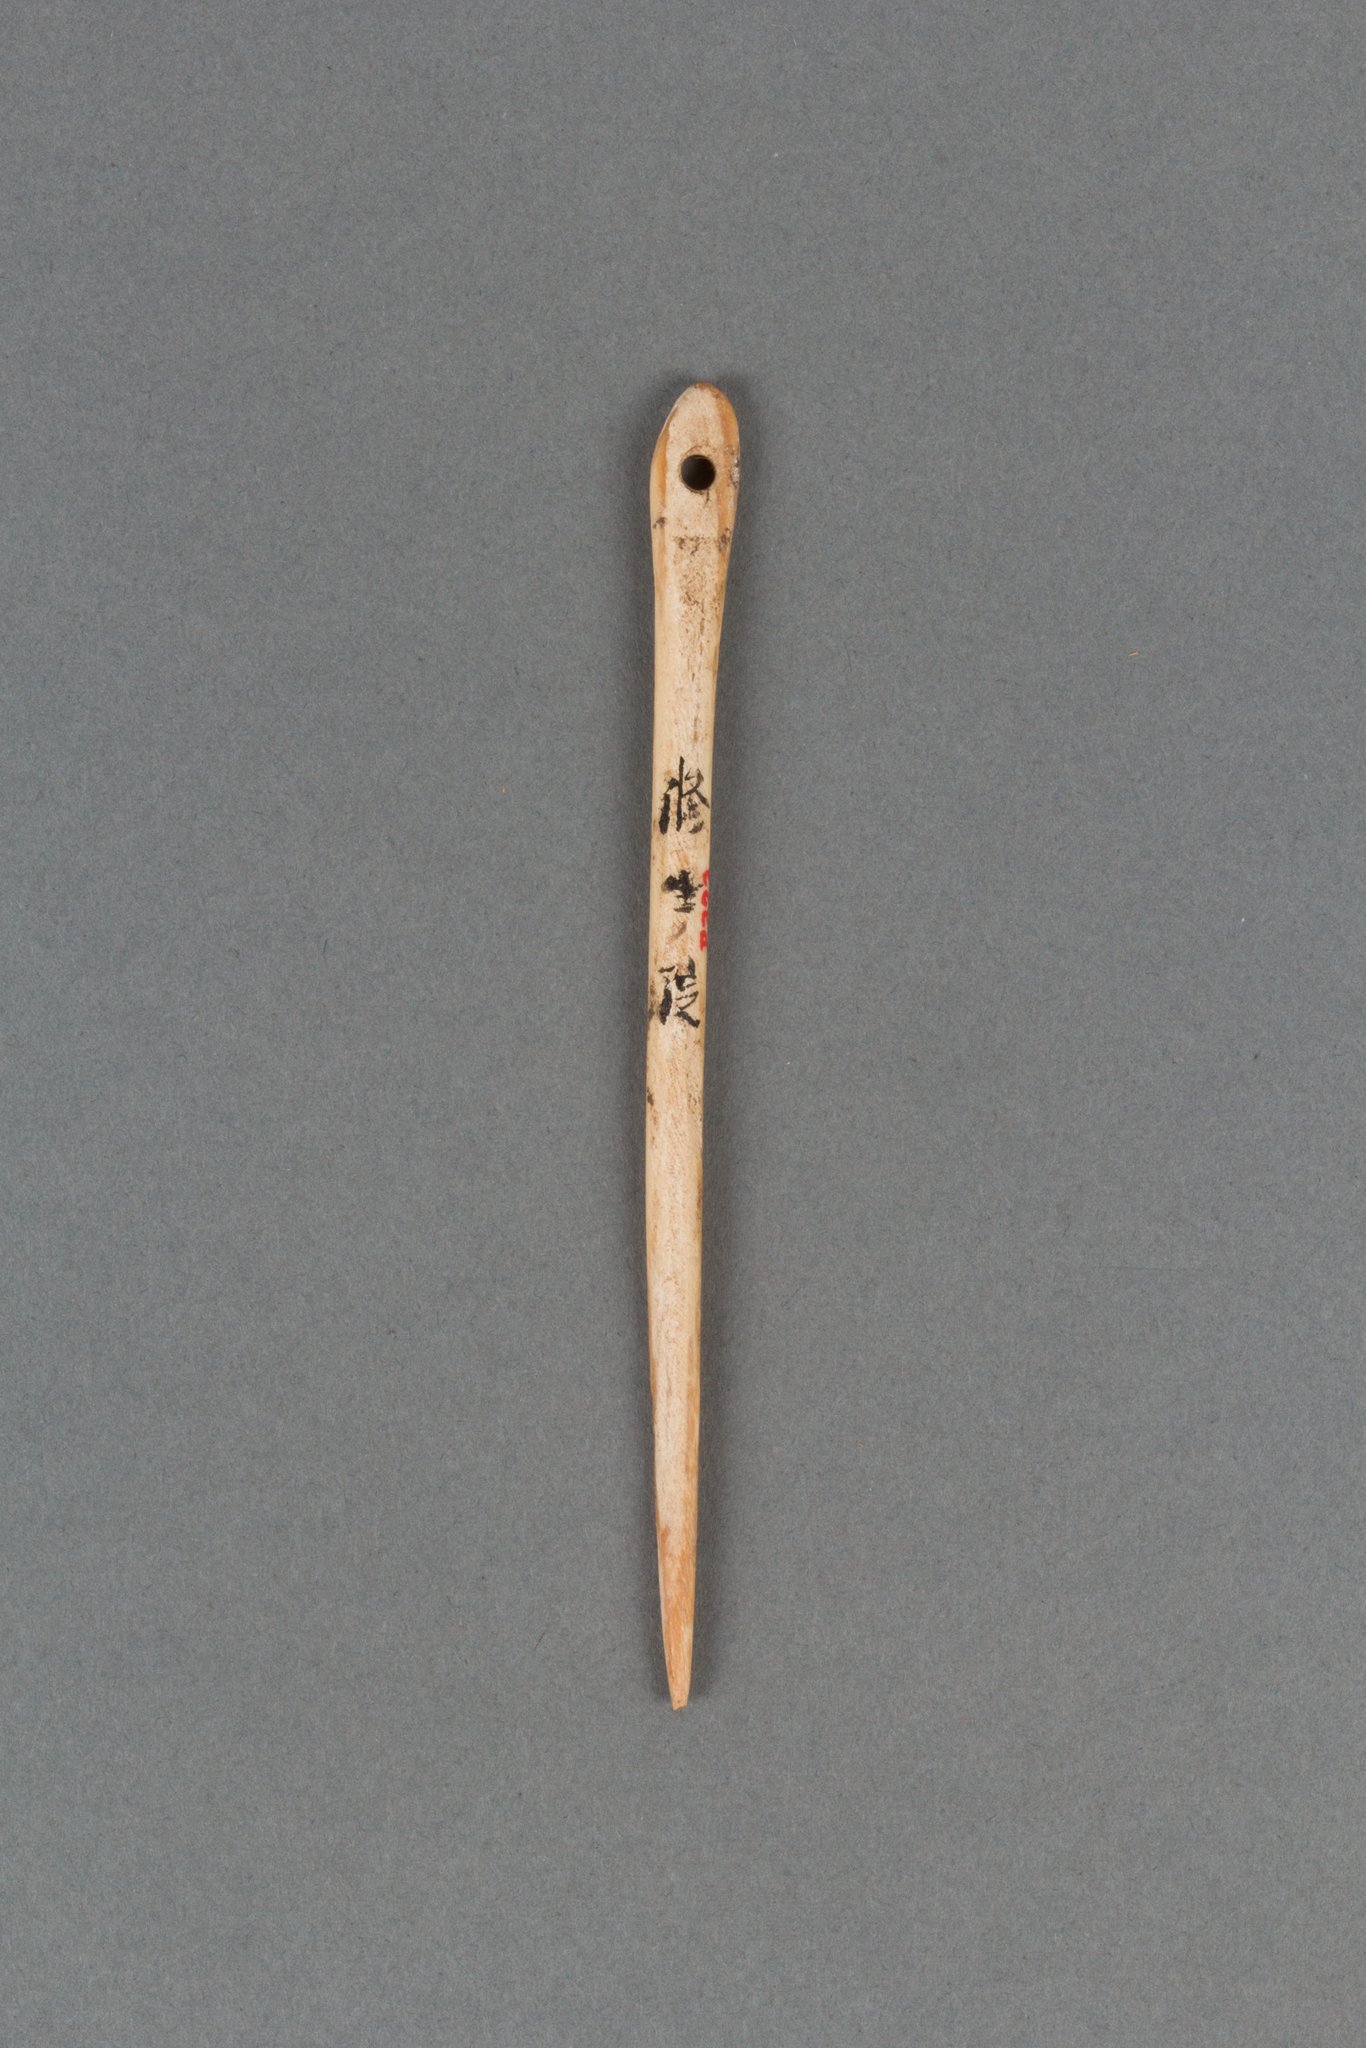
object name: needle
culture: japanese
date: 1200-200 BCE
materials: bone